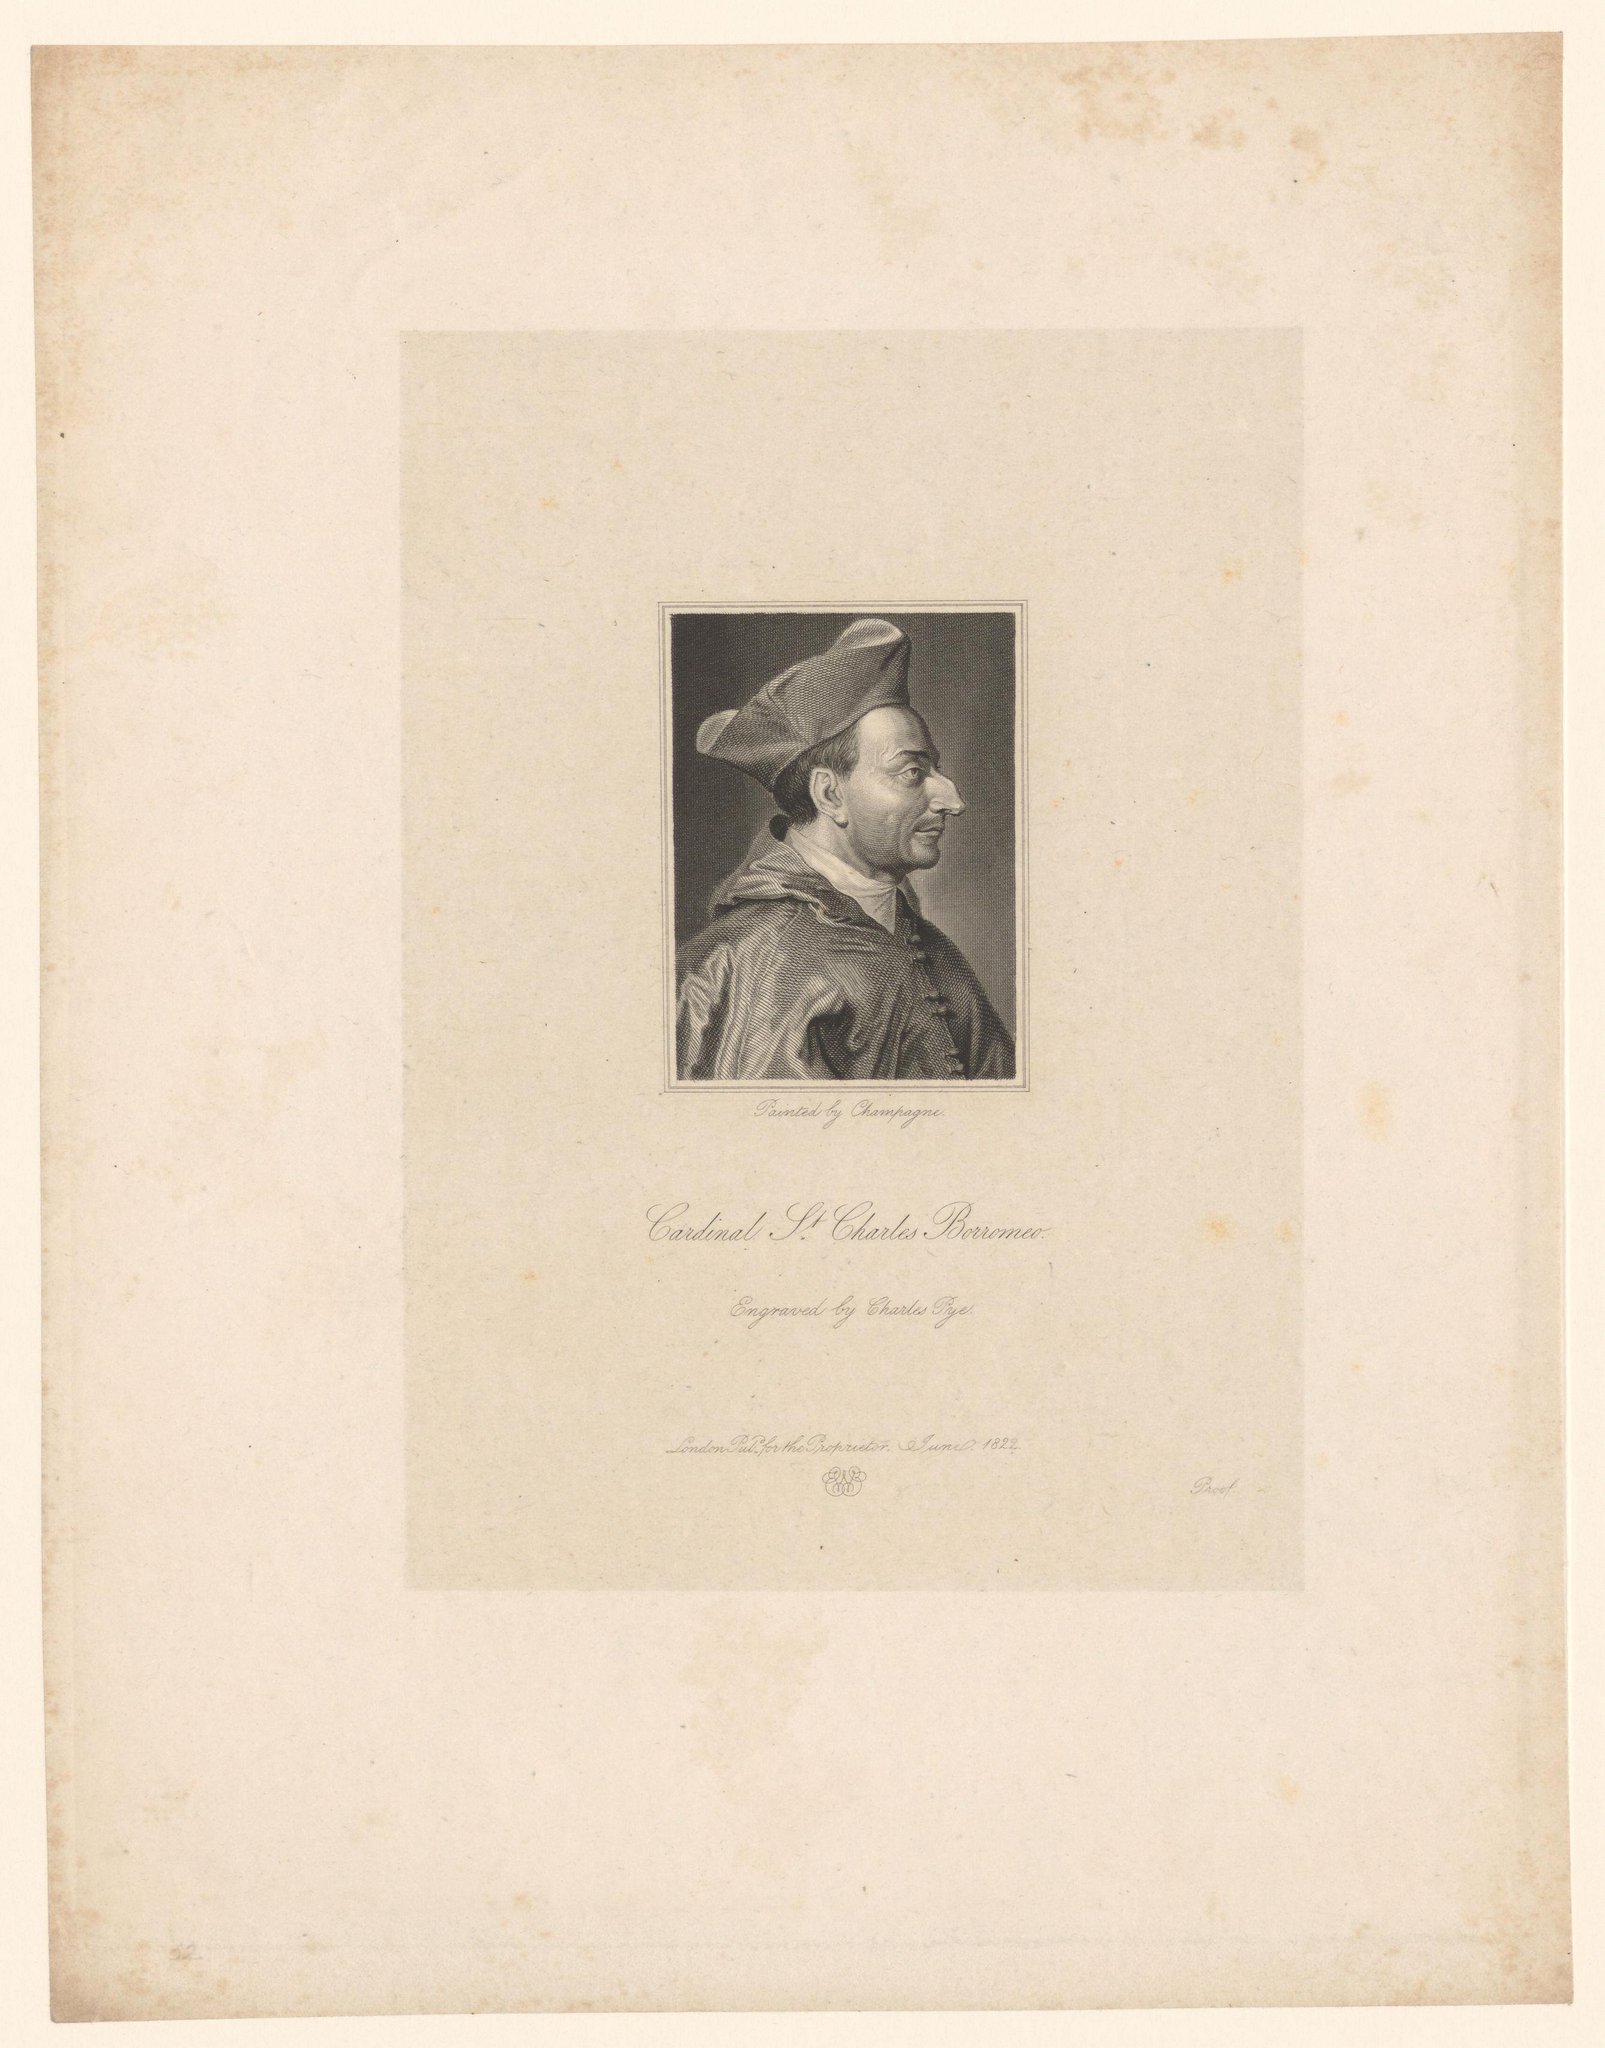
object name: print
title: Portret van Carlo Borromeo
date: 1822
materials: paper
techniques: engraving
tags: cardinal, historical persons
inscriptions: collector's mark: Lugt 2228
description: Prent gebruikt in: Walmsley, Edward. Physiognomical portraits. Londen: John Major, 1822.